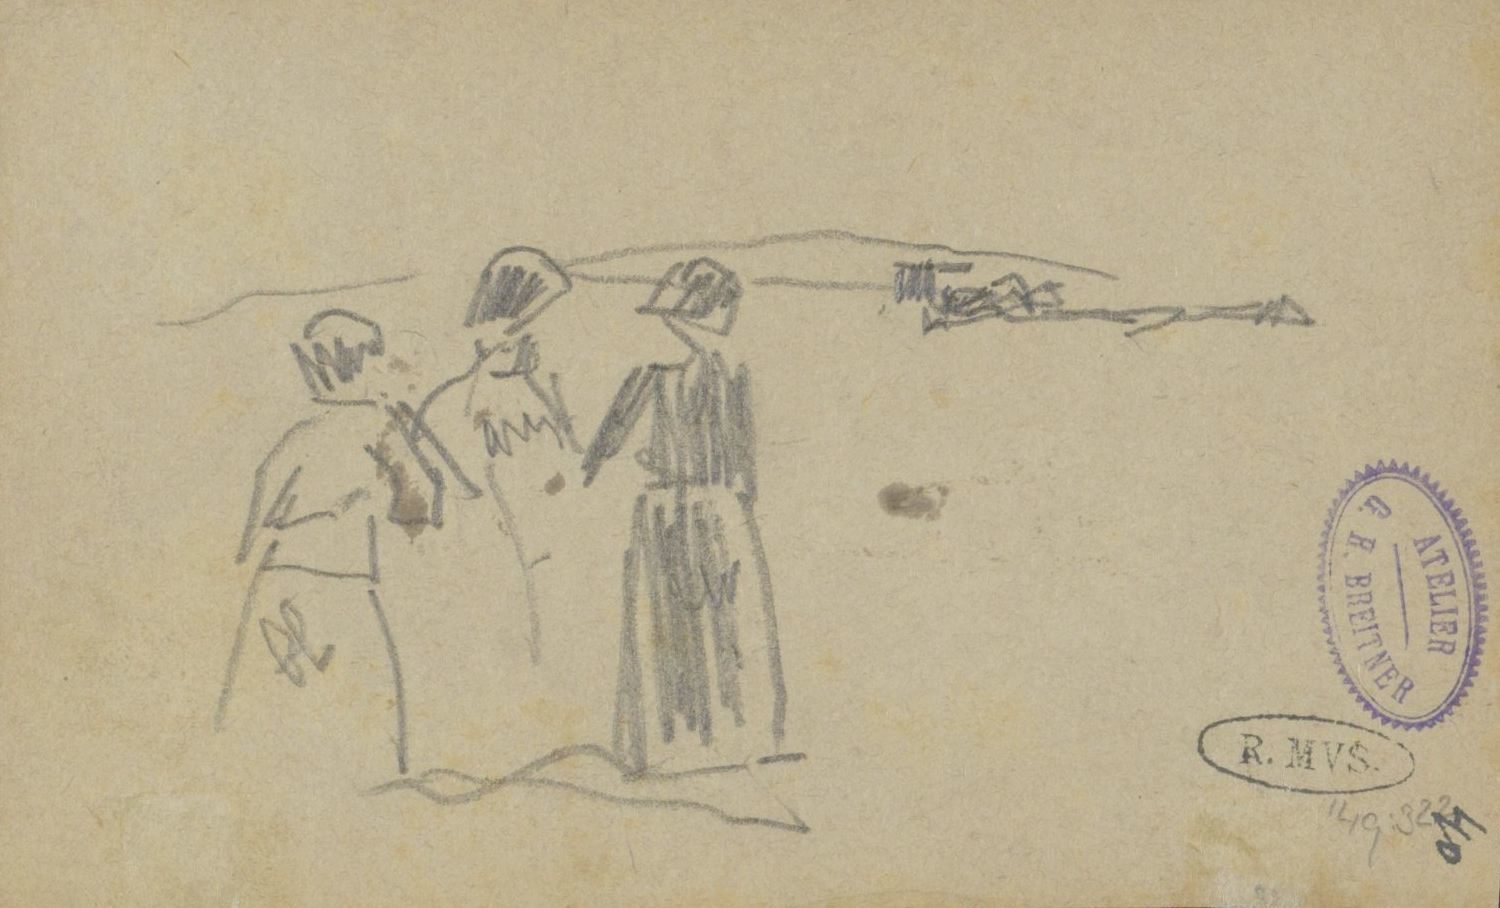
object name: drawing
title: Drie vrouwen in duinterrein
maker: george hendrik breitner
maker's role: draughtsman, painter, print maker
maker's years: 1857-1923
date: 1887-1891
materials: paper, pencil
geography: gelderland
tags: standing figure - aa - female human figure (+ three persons), landscapes in the temperate zone (+ landscape with figures, staffage)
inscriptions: collector's mark: Lugt 2228, workshop stamp: Lugt 291d